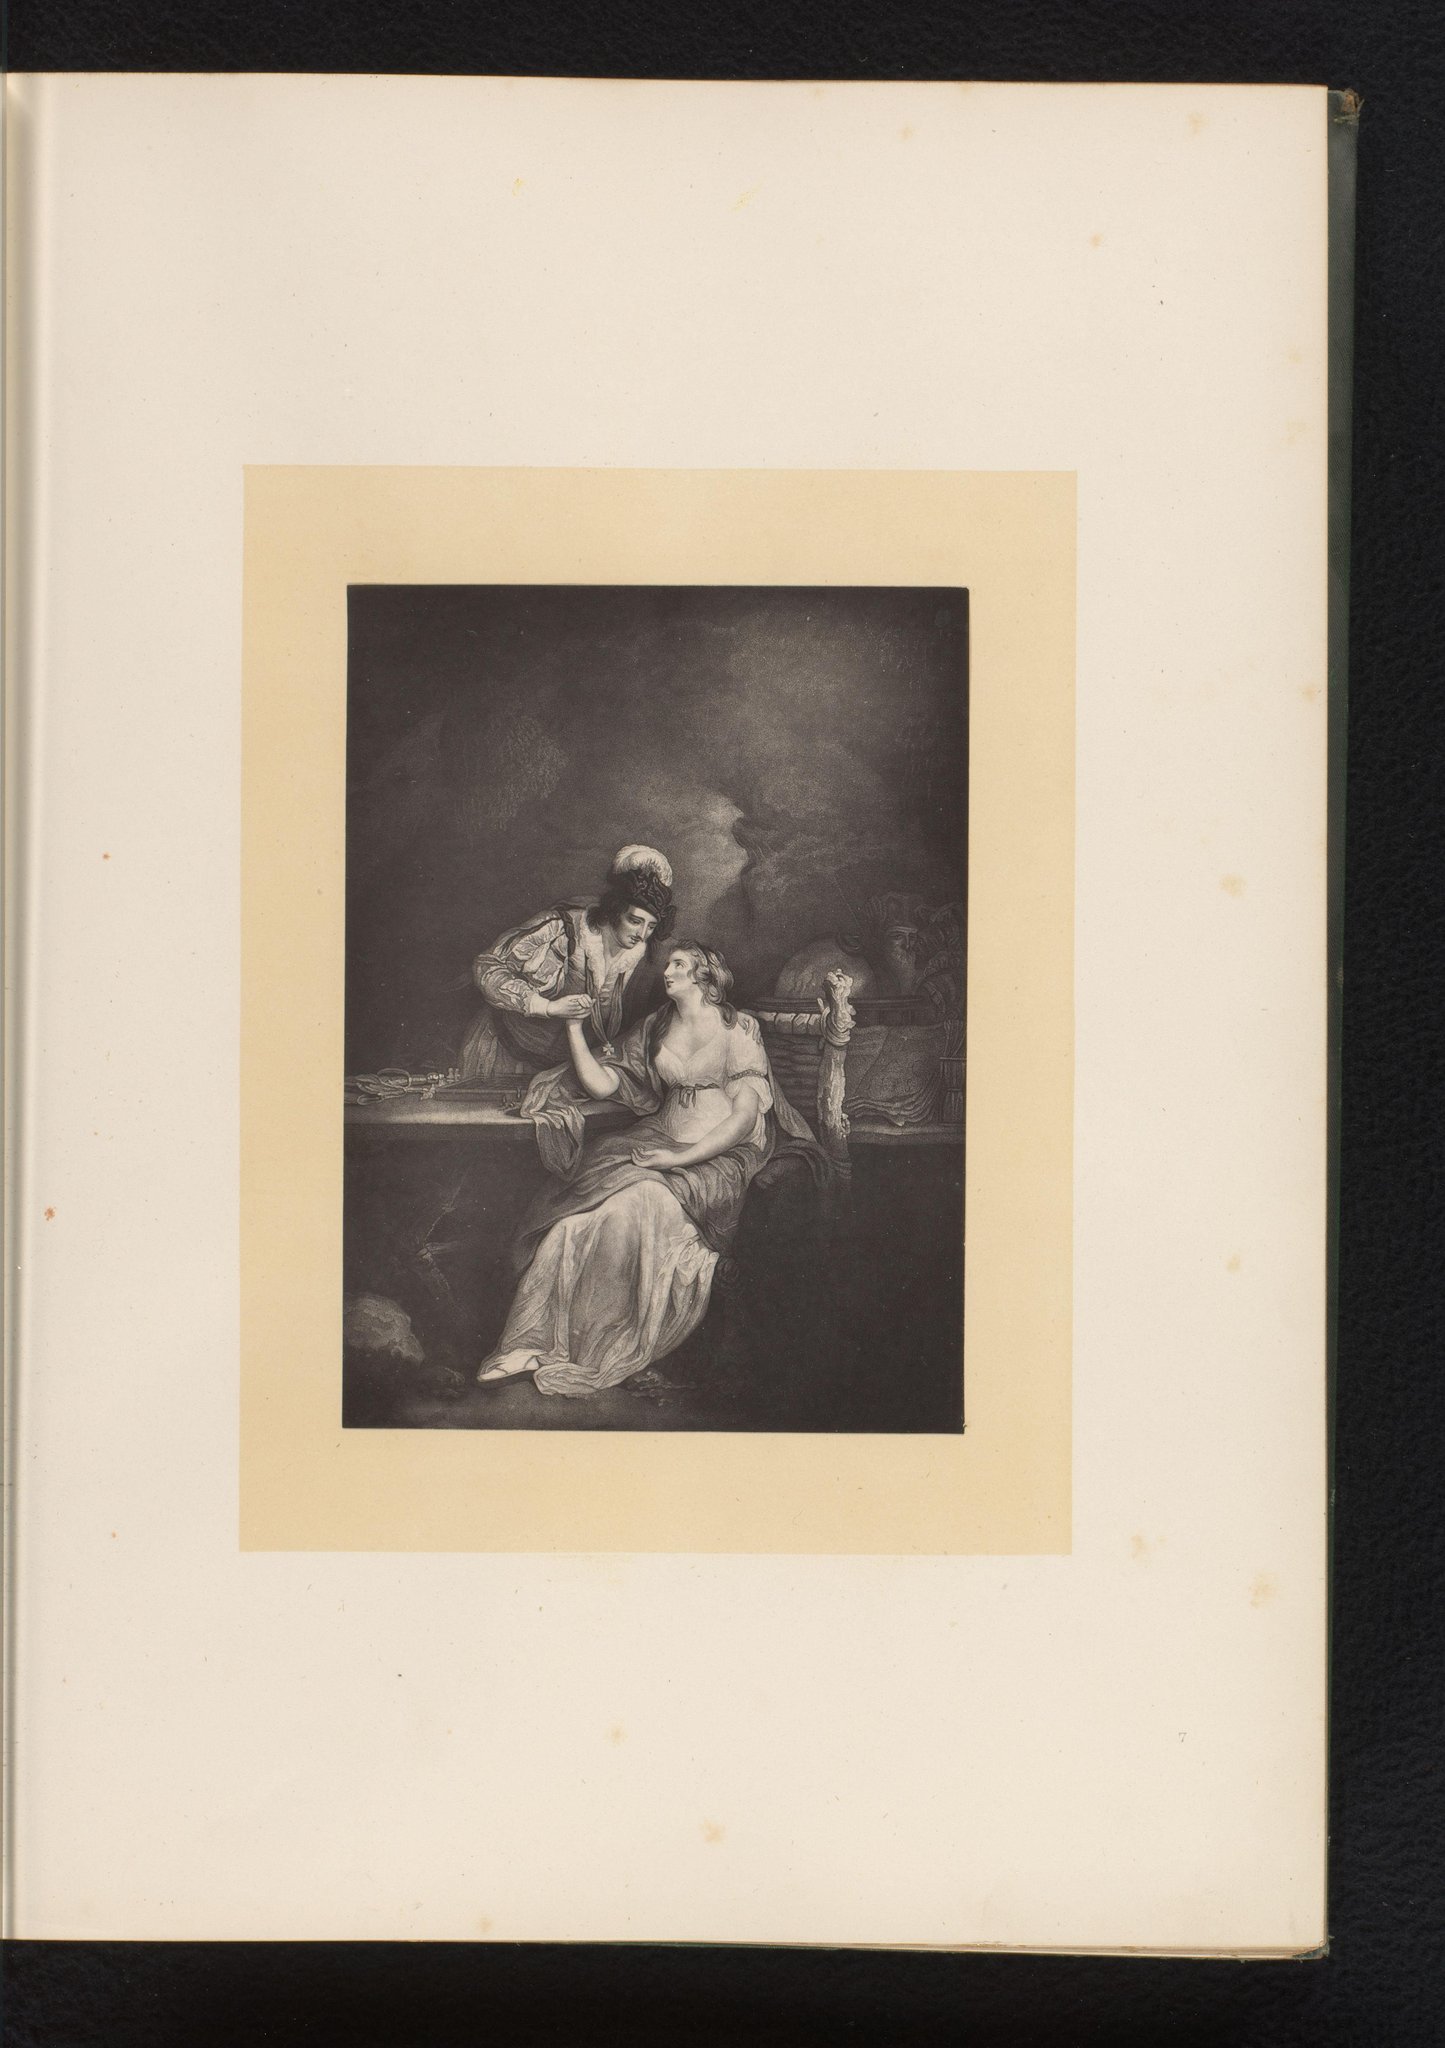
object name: photomechanical print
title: Reproductie van een gravure naar een schilderij van een scène uit The Tempest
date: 1874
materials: paper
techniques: woodburytype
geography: london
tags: (scenes from) specific works of literature: shakespeare, tempest